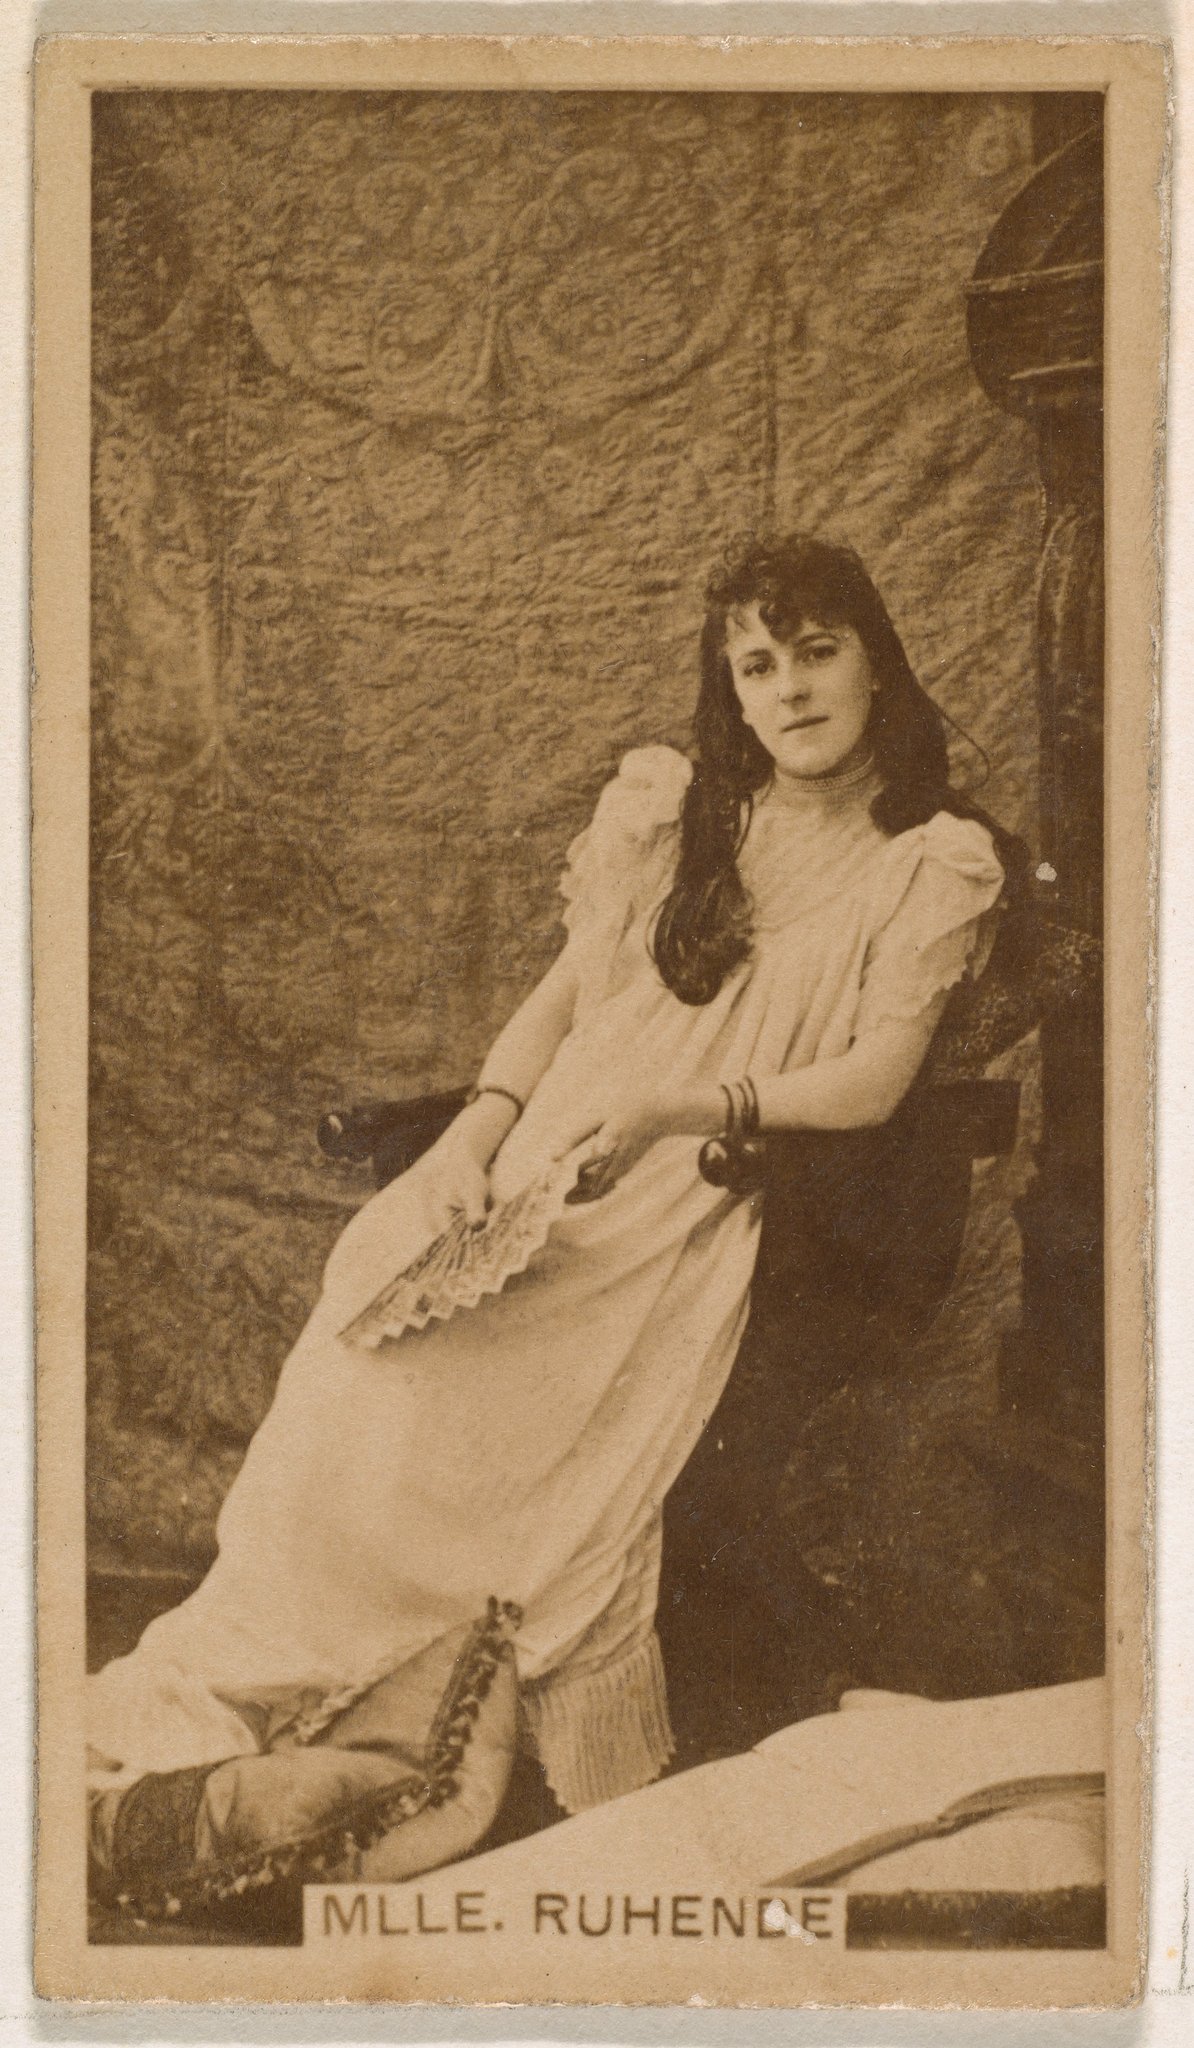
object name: photograph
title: Mlle. Ruhende, from the Actresses series (N245) issued by Kinney Brothers to promote Sweet Caporal Cigarettes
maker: kinney brothers tobacco company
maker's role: publisher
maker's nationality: american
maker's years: 1869-2011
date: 1890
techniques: albumen silver print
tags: portraits,women,actresses